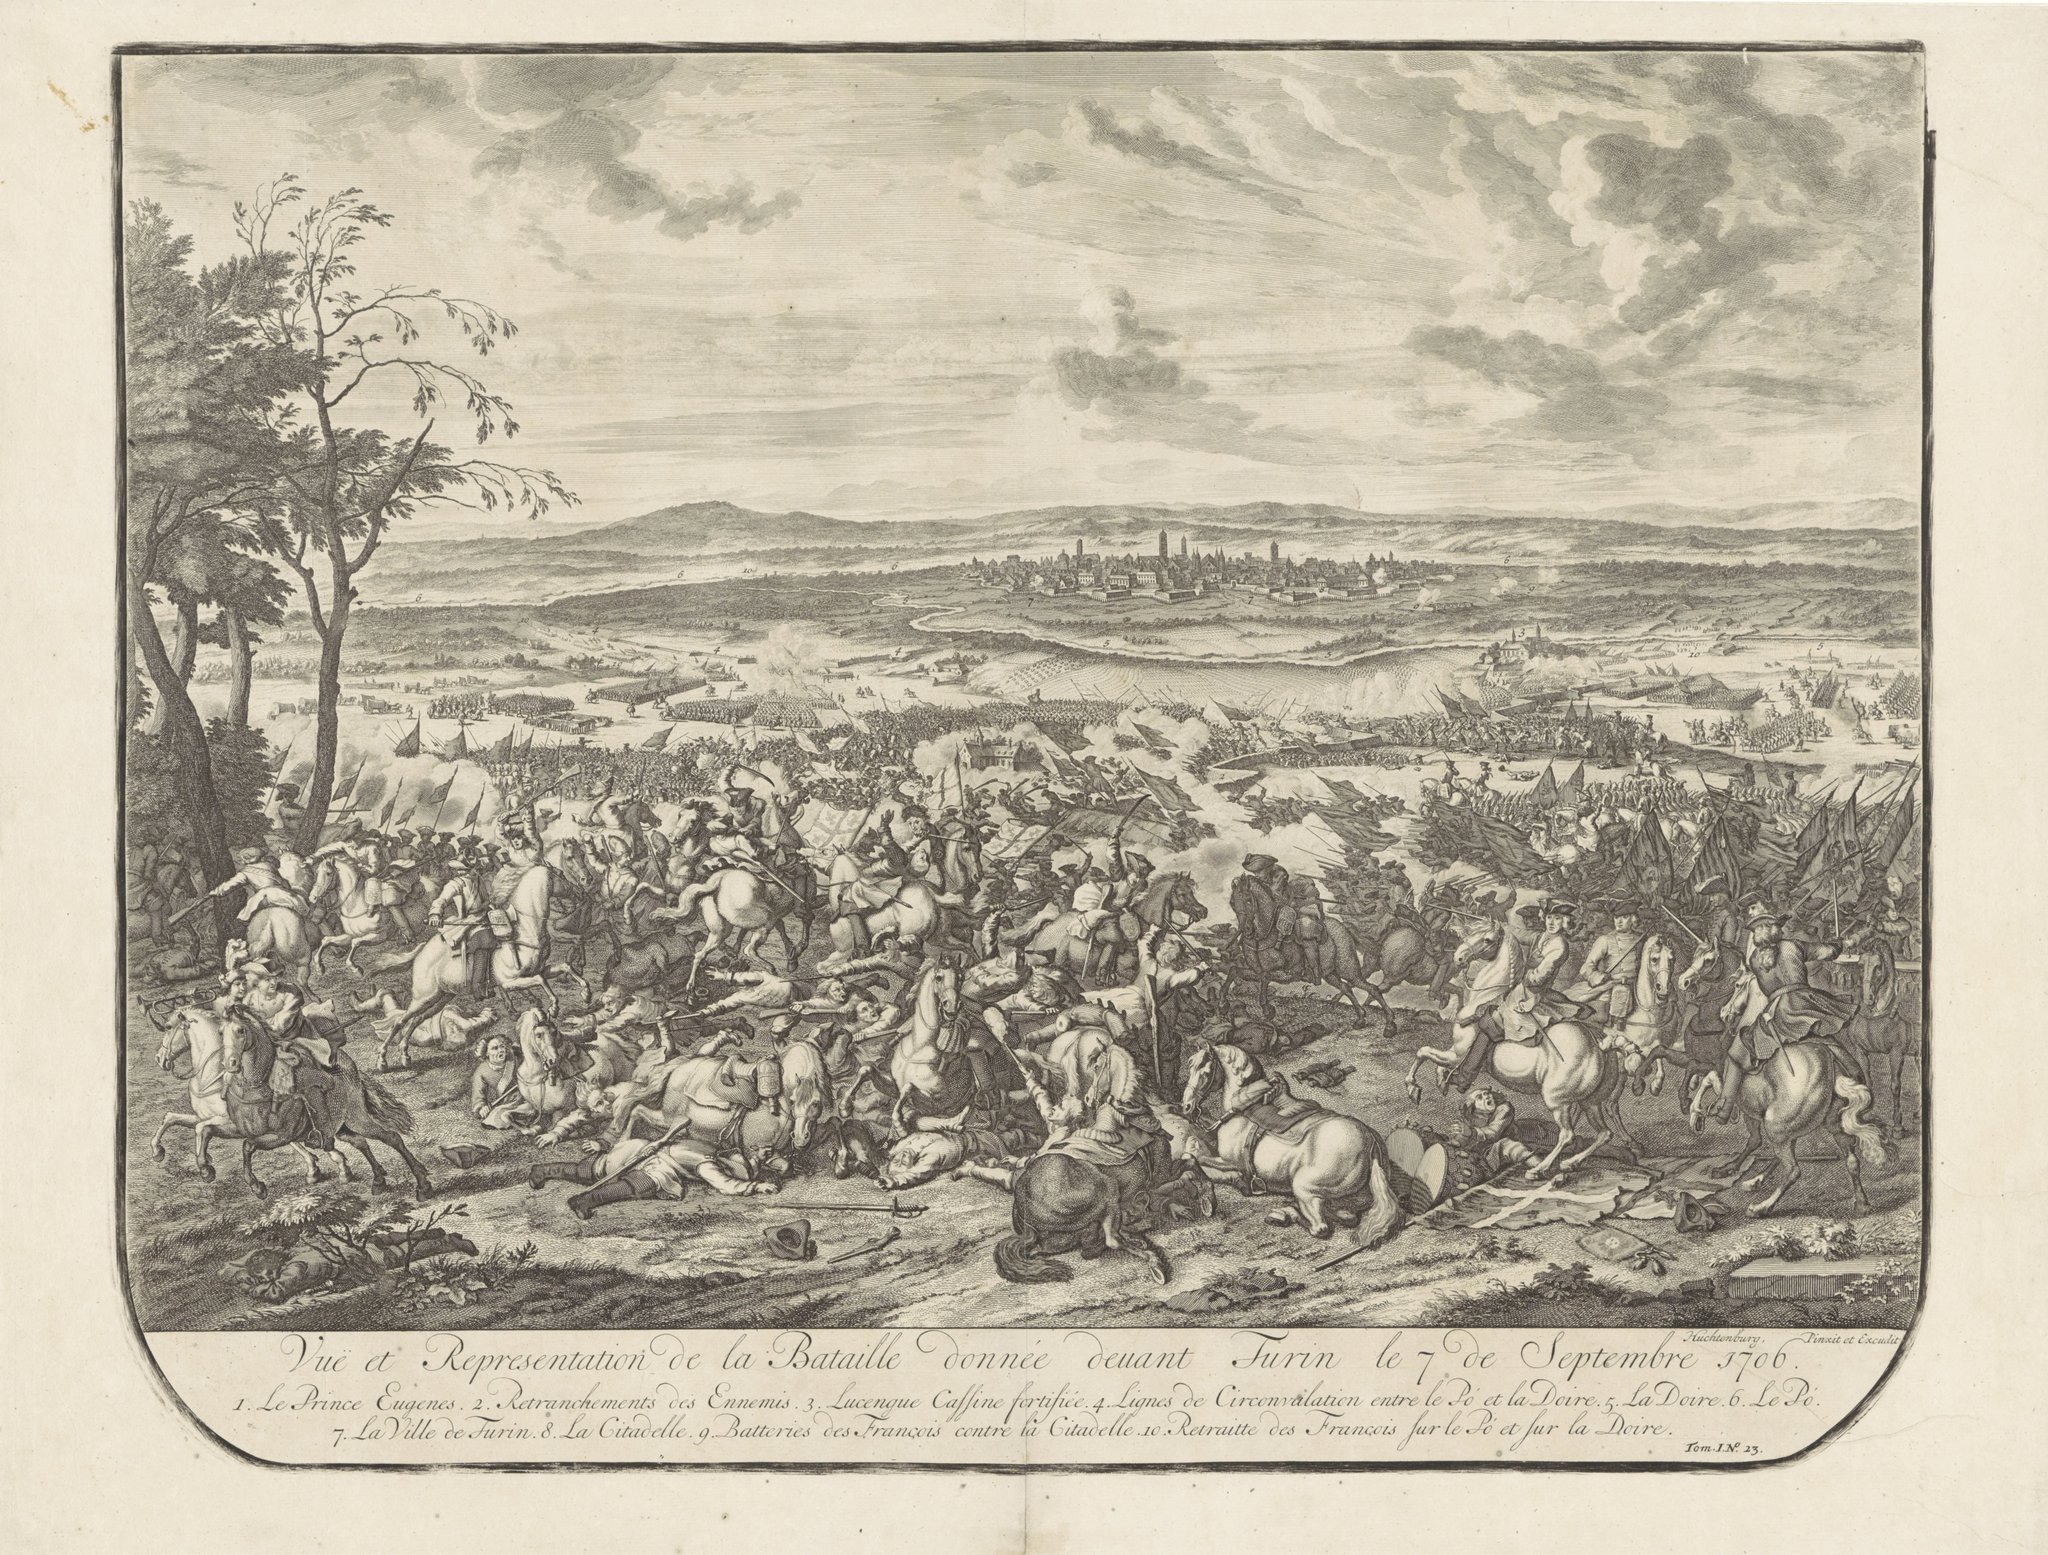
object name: print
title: Vuë et representation de la bataille donnée devant Turin le 7 de septembre 1706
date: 1729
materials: paper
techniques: engraving, etching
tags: paris, vienna, eugenius van savoye, raising the siege with outside assistance, relief, battle (+ land forces)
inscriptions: collector's mark: Lugt 2228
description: Prent mogelijk gebruikt in: Jean Du Mont baron de Carels-Croon, Oorlogskundige beschryving van de veldslagen (...) der drie (...) krygsoversten (...) den prins Eugenius van Savoye, den prins en hertog van Marlborough, en den prins van Oranje- en Nassau-Vriesland, 's-Gravenhage: Isaac van der Kloot, 1729. Deel 1, nr. 23.